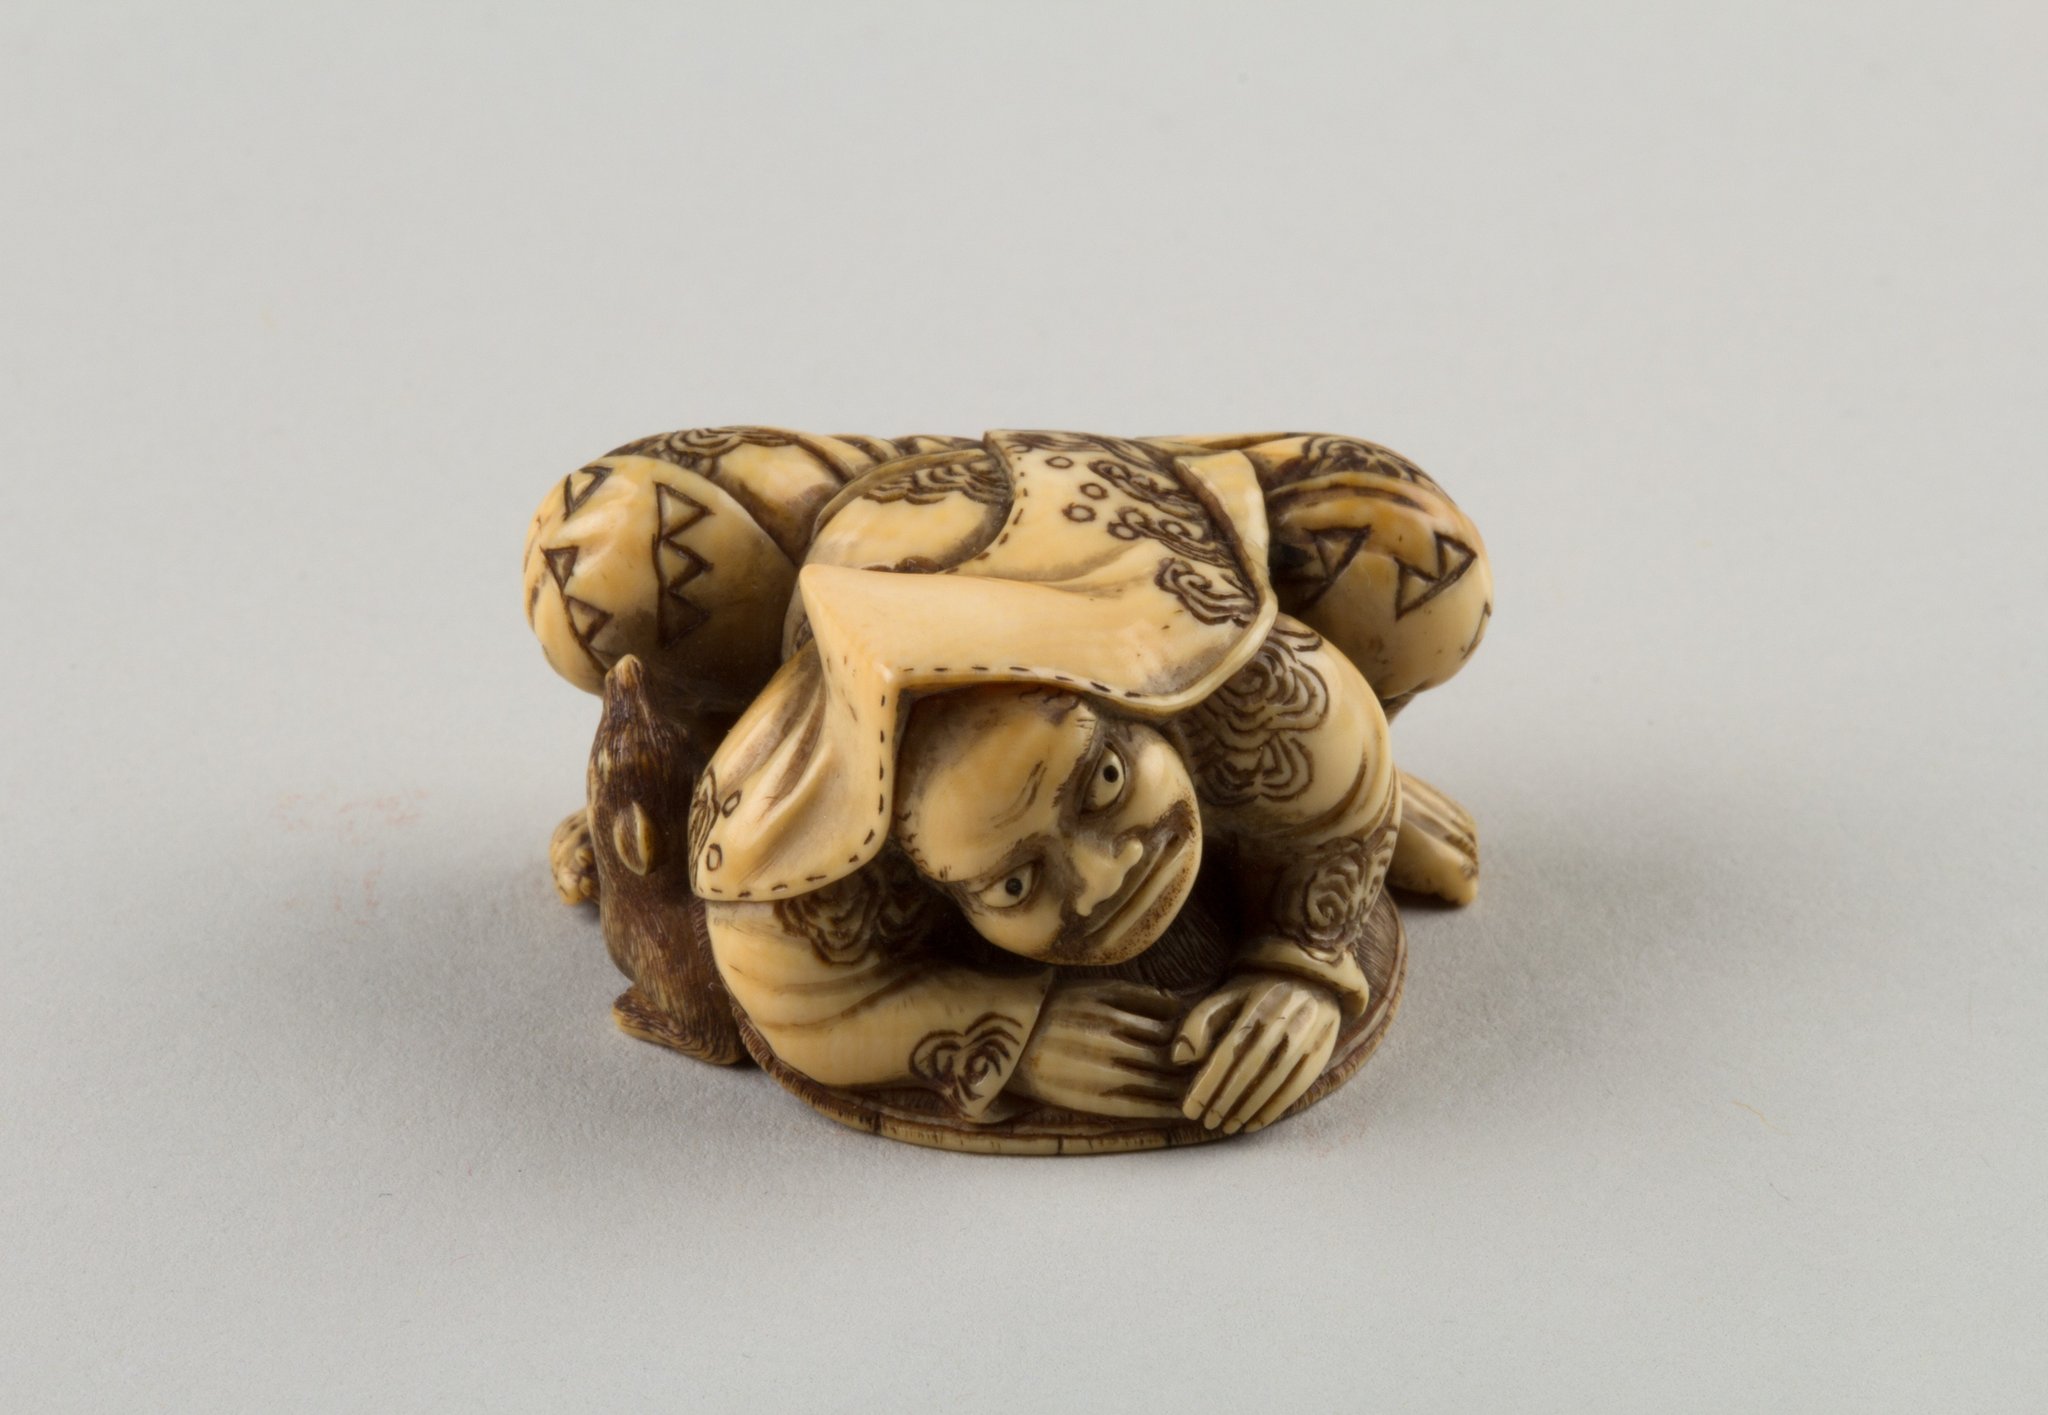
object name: netsuke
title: Netsuke of a Hunter Trying to Catch a Fox Beneath a Straw Hat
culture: japanese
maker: shūōsai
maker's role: artist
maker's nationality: japanese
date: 1801-1833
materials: ivory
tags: men,foxes